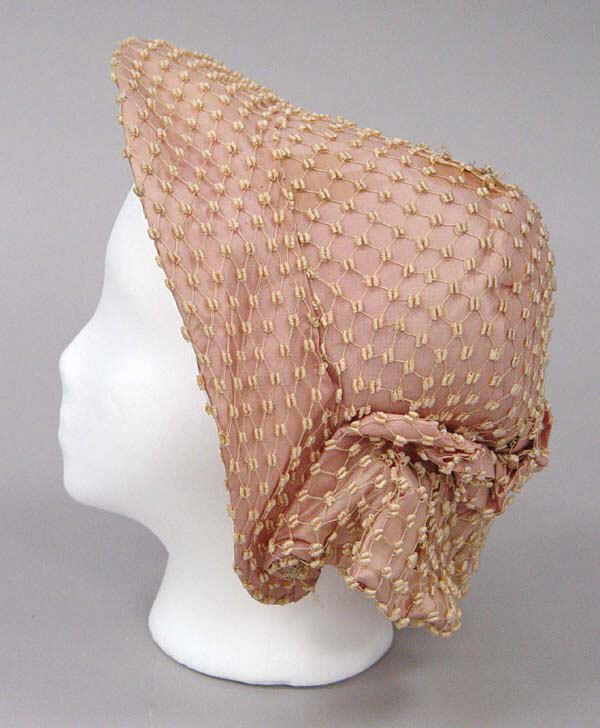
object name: bonnet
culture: american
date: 1863-1867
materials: silk